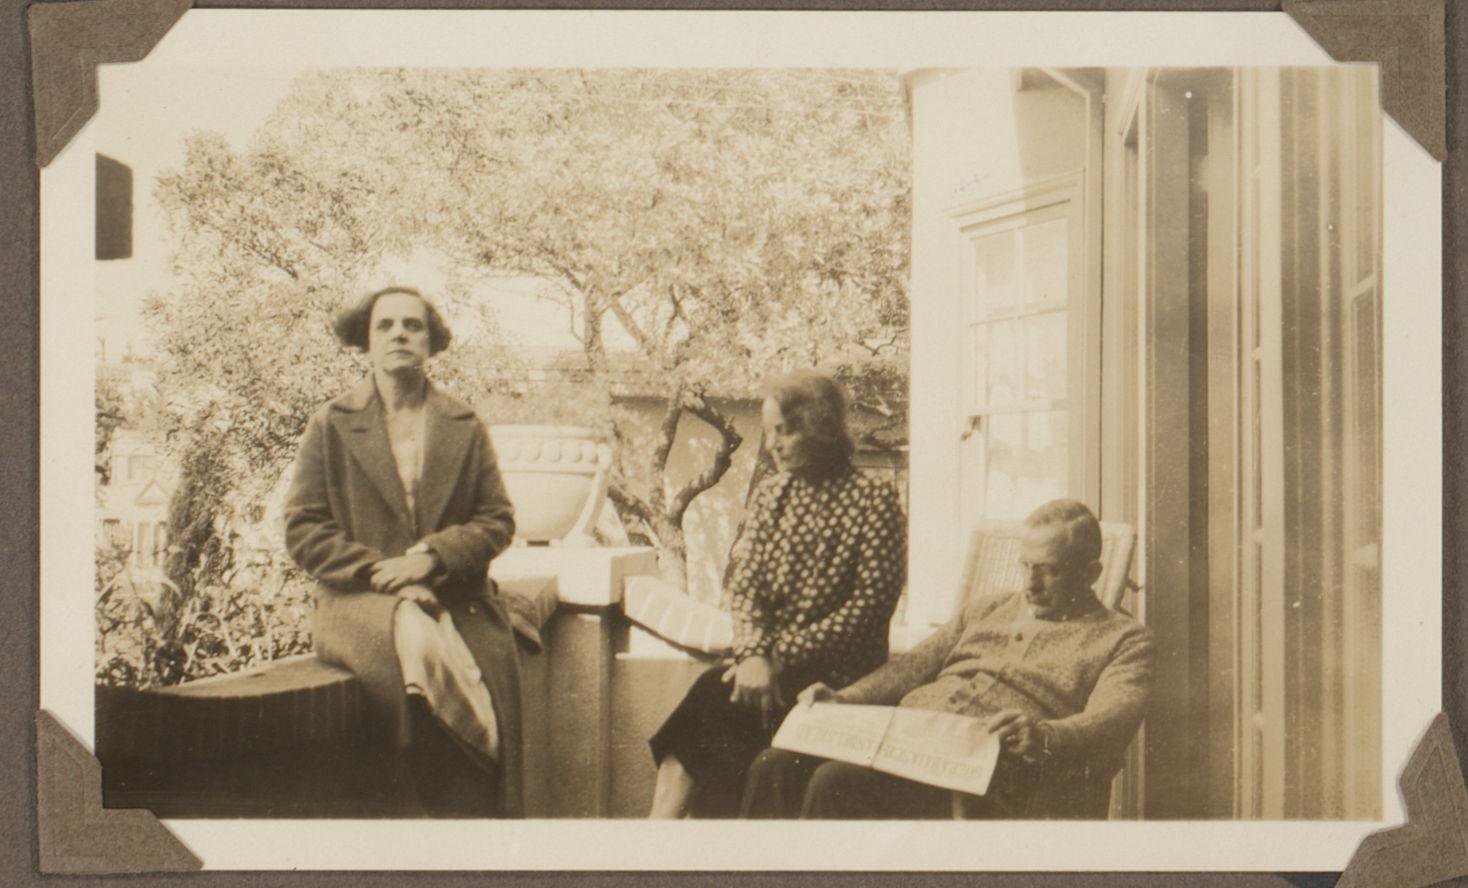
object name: photograph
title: Twee vrouwen en een man op een balkon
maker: Anonymous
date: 1930-1935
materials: paper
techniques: gelatin silver print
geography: dutch east indies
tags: adult woman, reading, adult man, dutch east indies, the